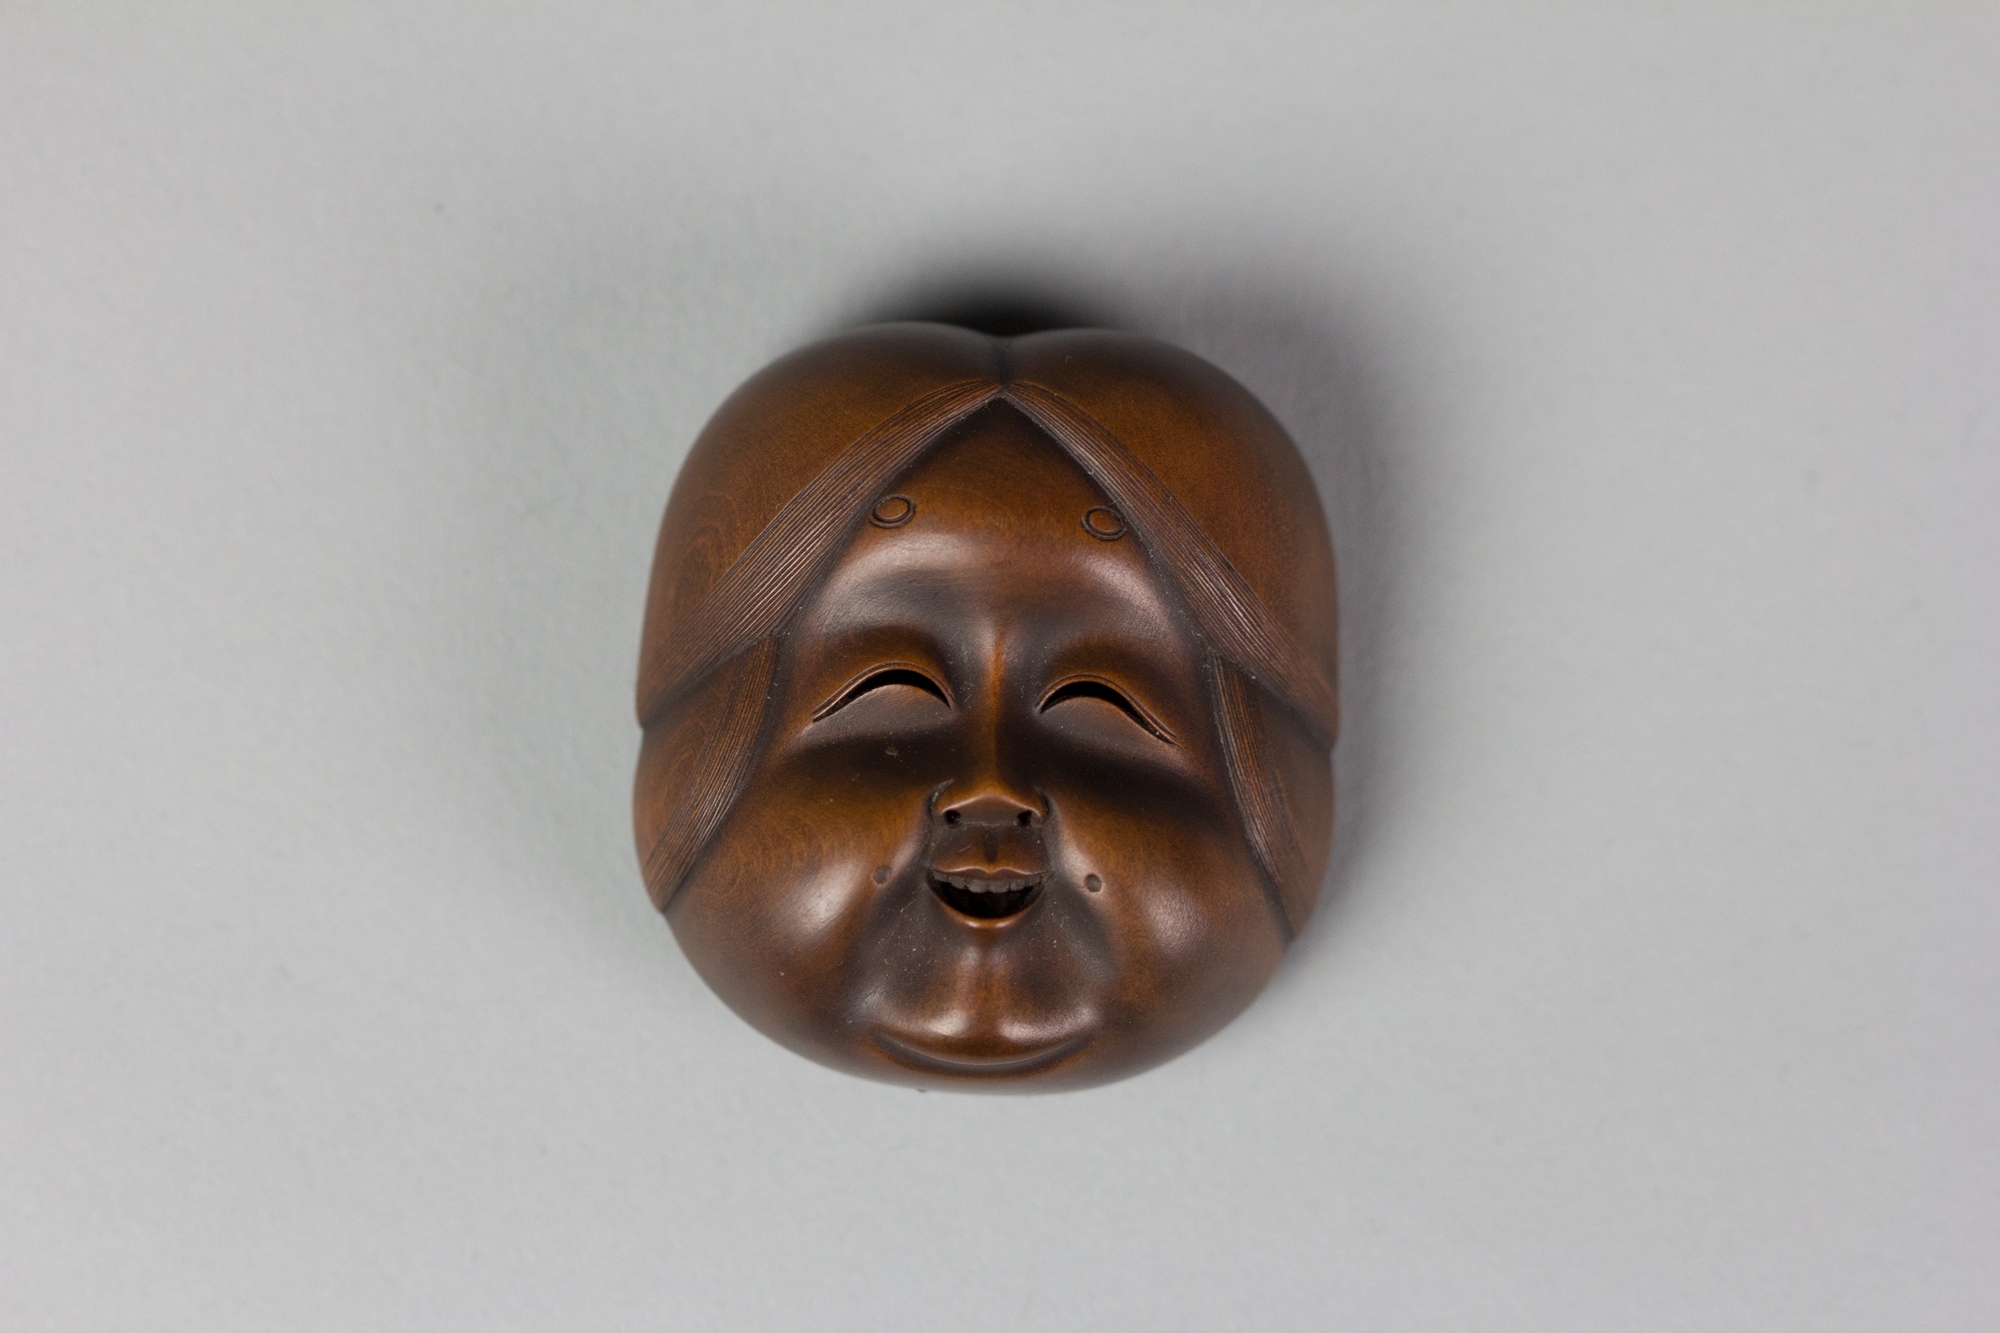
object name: netsuke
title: Netsuke of Kyōgen Mask: Usume (or Ofuku or Okame)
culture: japanese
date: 1801-1900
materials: wood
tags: masks